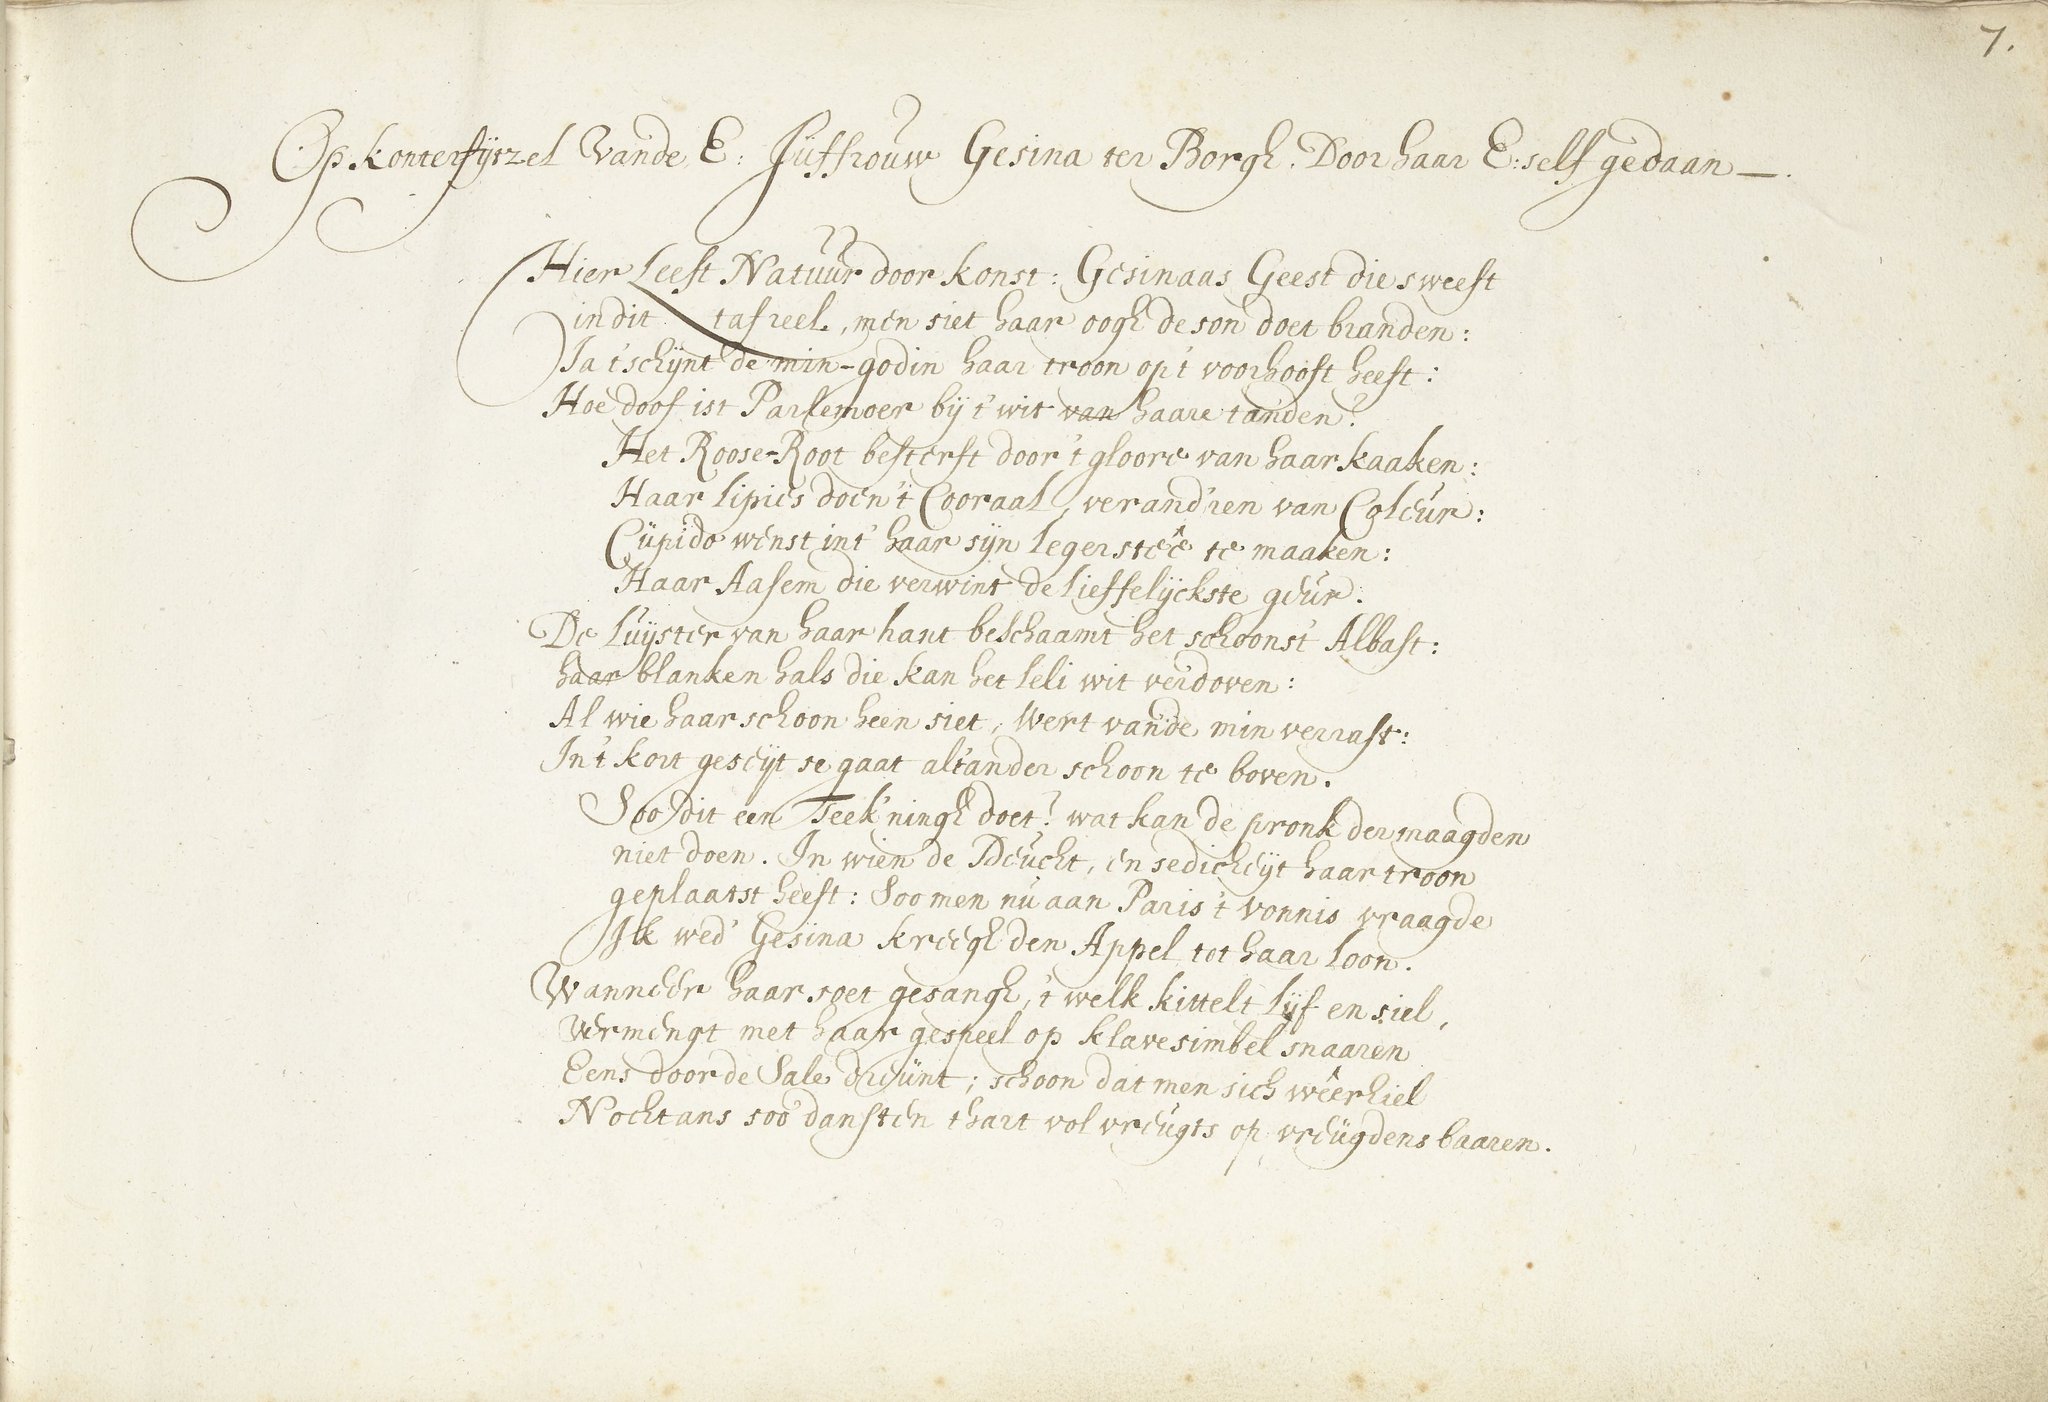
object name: poem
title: Op konterfijtzel vande E.Juffrouw Gesina ter Borgh: Door haar E:self gedaan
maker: henrik jordis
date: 1660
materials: ink, paper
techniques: writing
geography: zwolle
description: Gedicht naar aanleiding van het zelfportret van Gesina ter Borch op de volgende pagina van het album (BI-1887-1463-8).